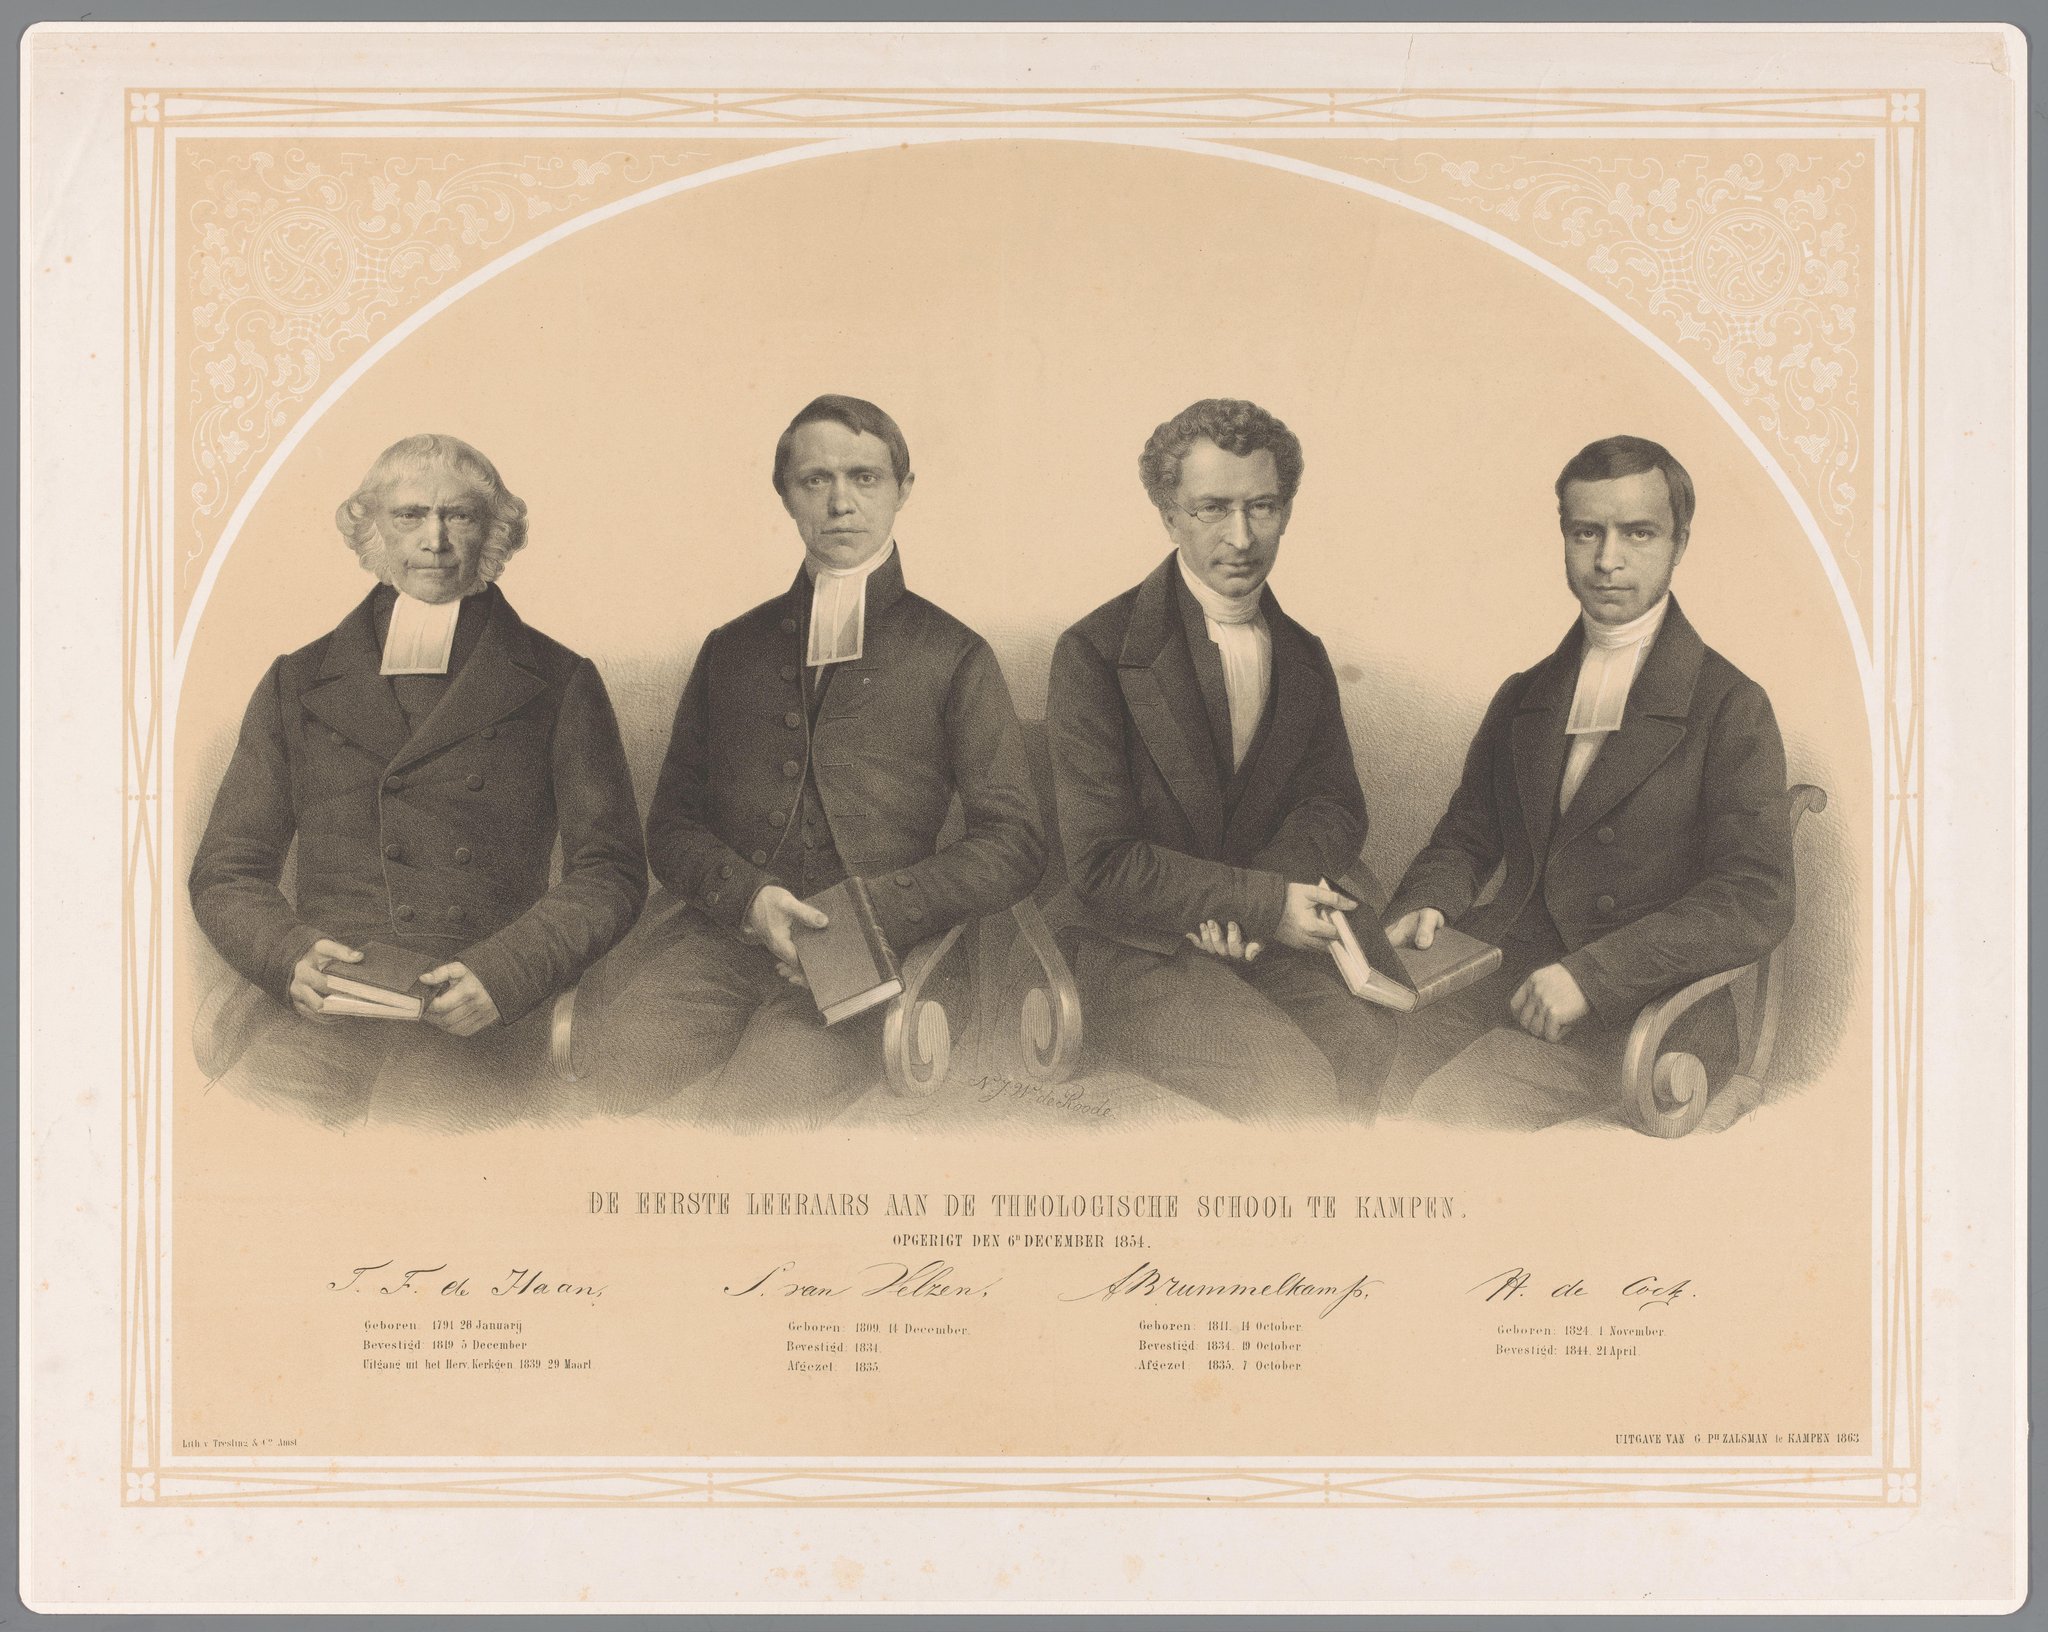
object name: print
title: De eerste leeraars aan de Theologische school te Kampen, opgerigt den 6n december 1854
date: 1863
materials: paper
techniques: tone lithography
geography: amsterdam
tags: amsterdam, scholar, philosopher, professor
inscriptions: collector's mark: Lugt 2228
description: Van links naar rechts: Tammes Foppes de Haan, Simon van Velzen, Anthony Brummelkamp en Helenius de Cock.